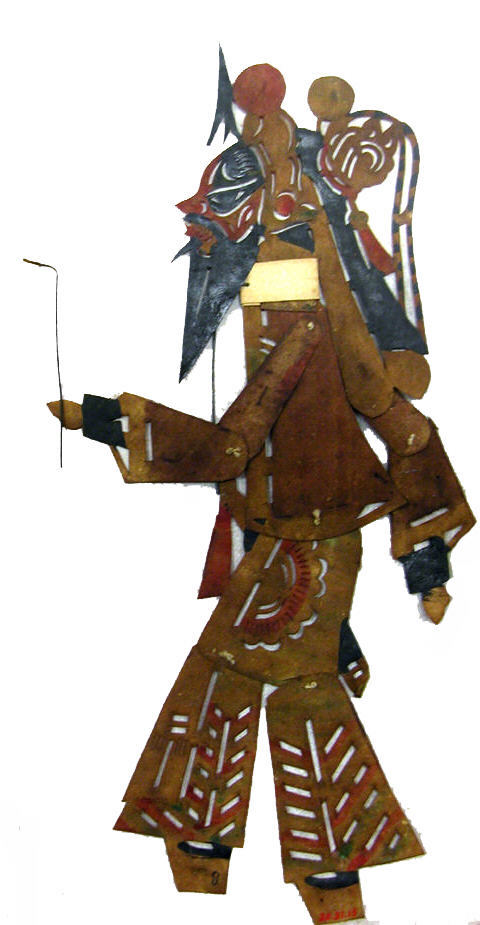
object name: shadow player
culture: chinese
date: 1801-1900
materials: cord, skin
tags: men